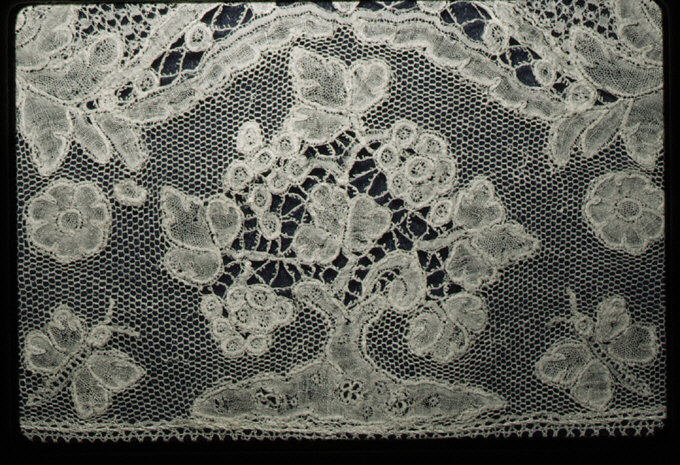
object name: border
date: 1701-1800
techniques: lace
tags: butterflies,flowers